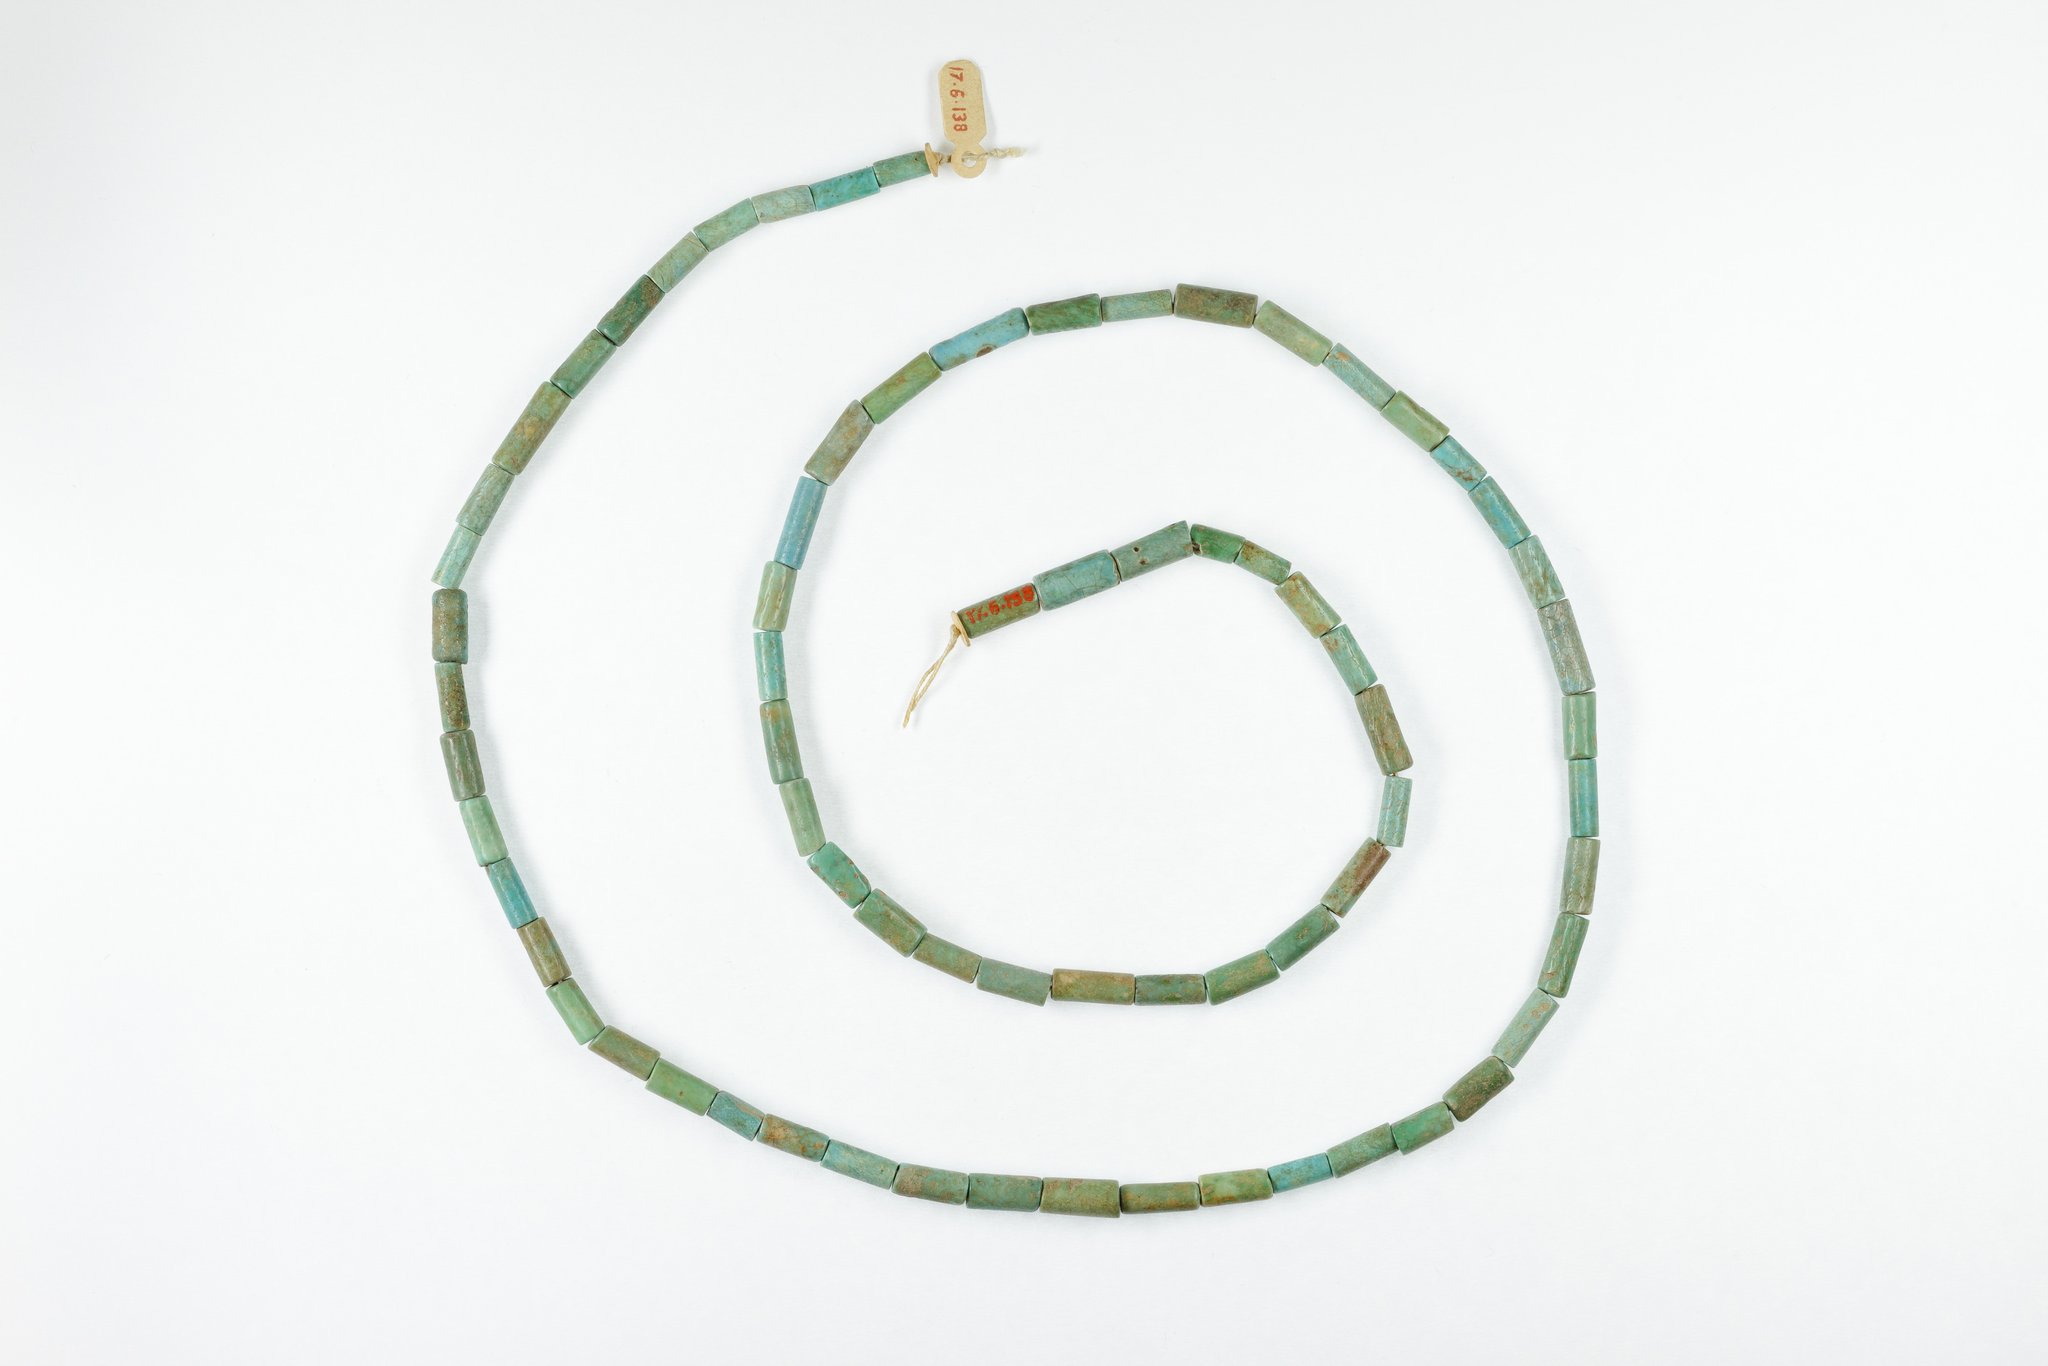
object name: bead, string, cylinder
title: String of Cylindrical Beads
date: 1550-1295 BCE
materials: faience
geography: northern upper egypt